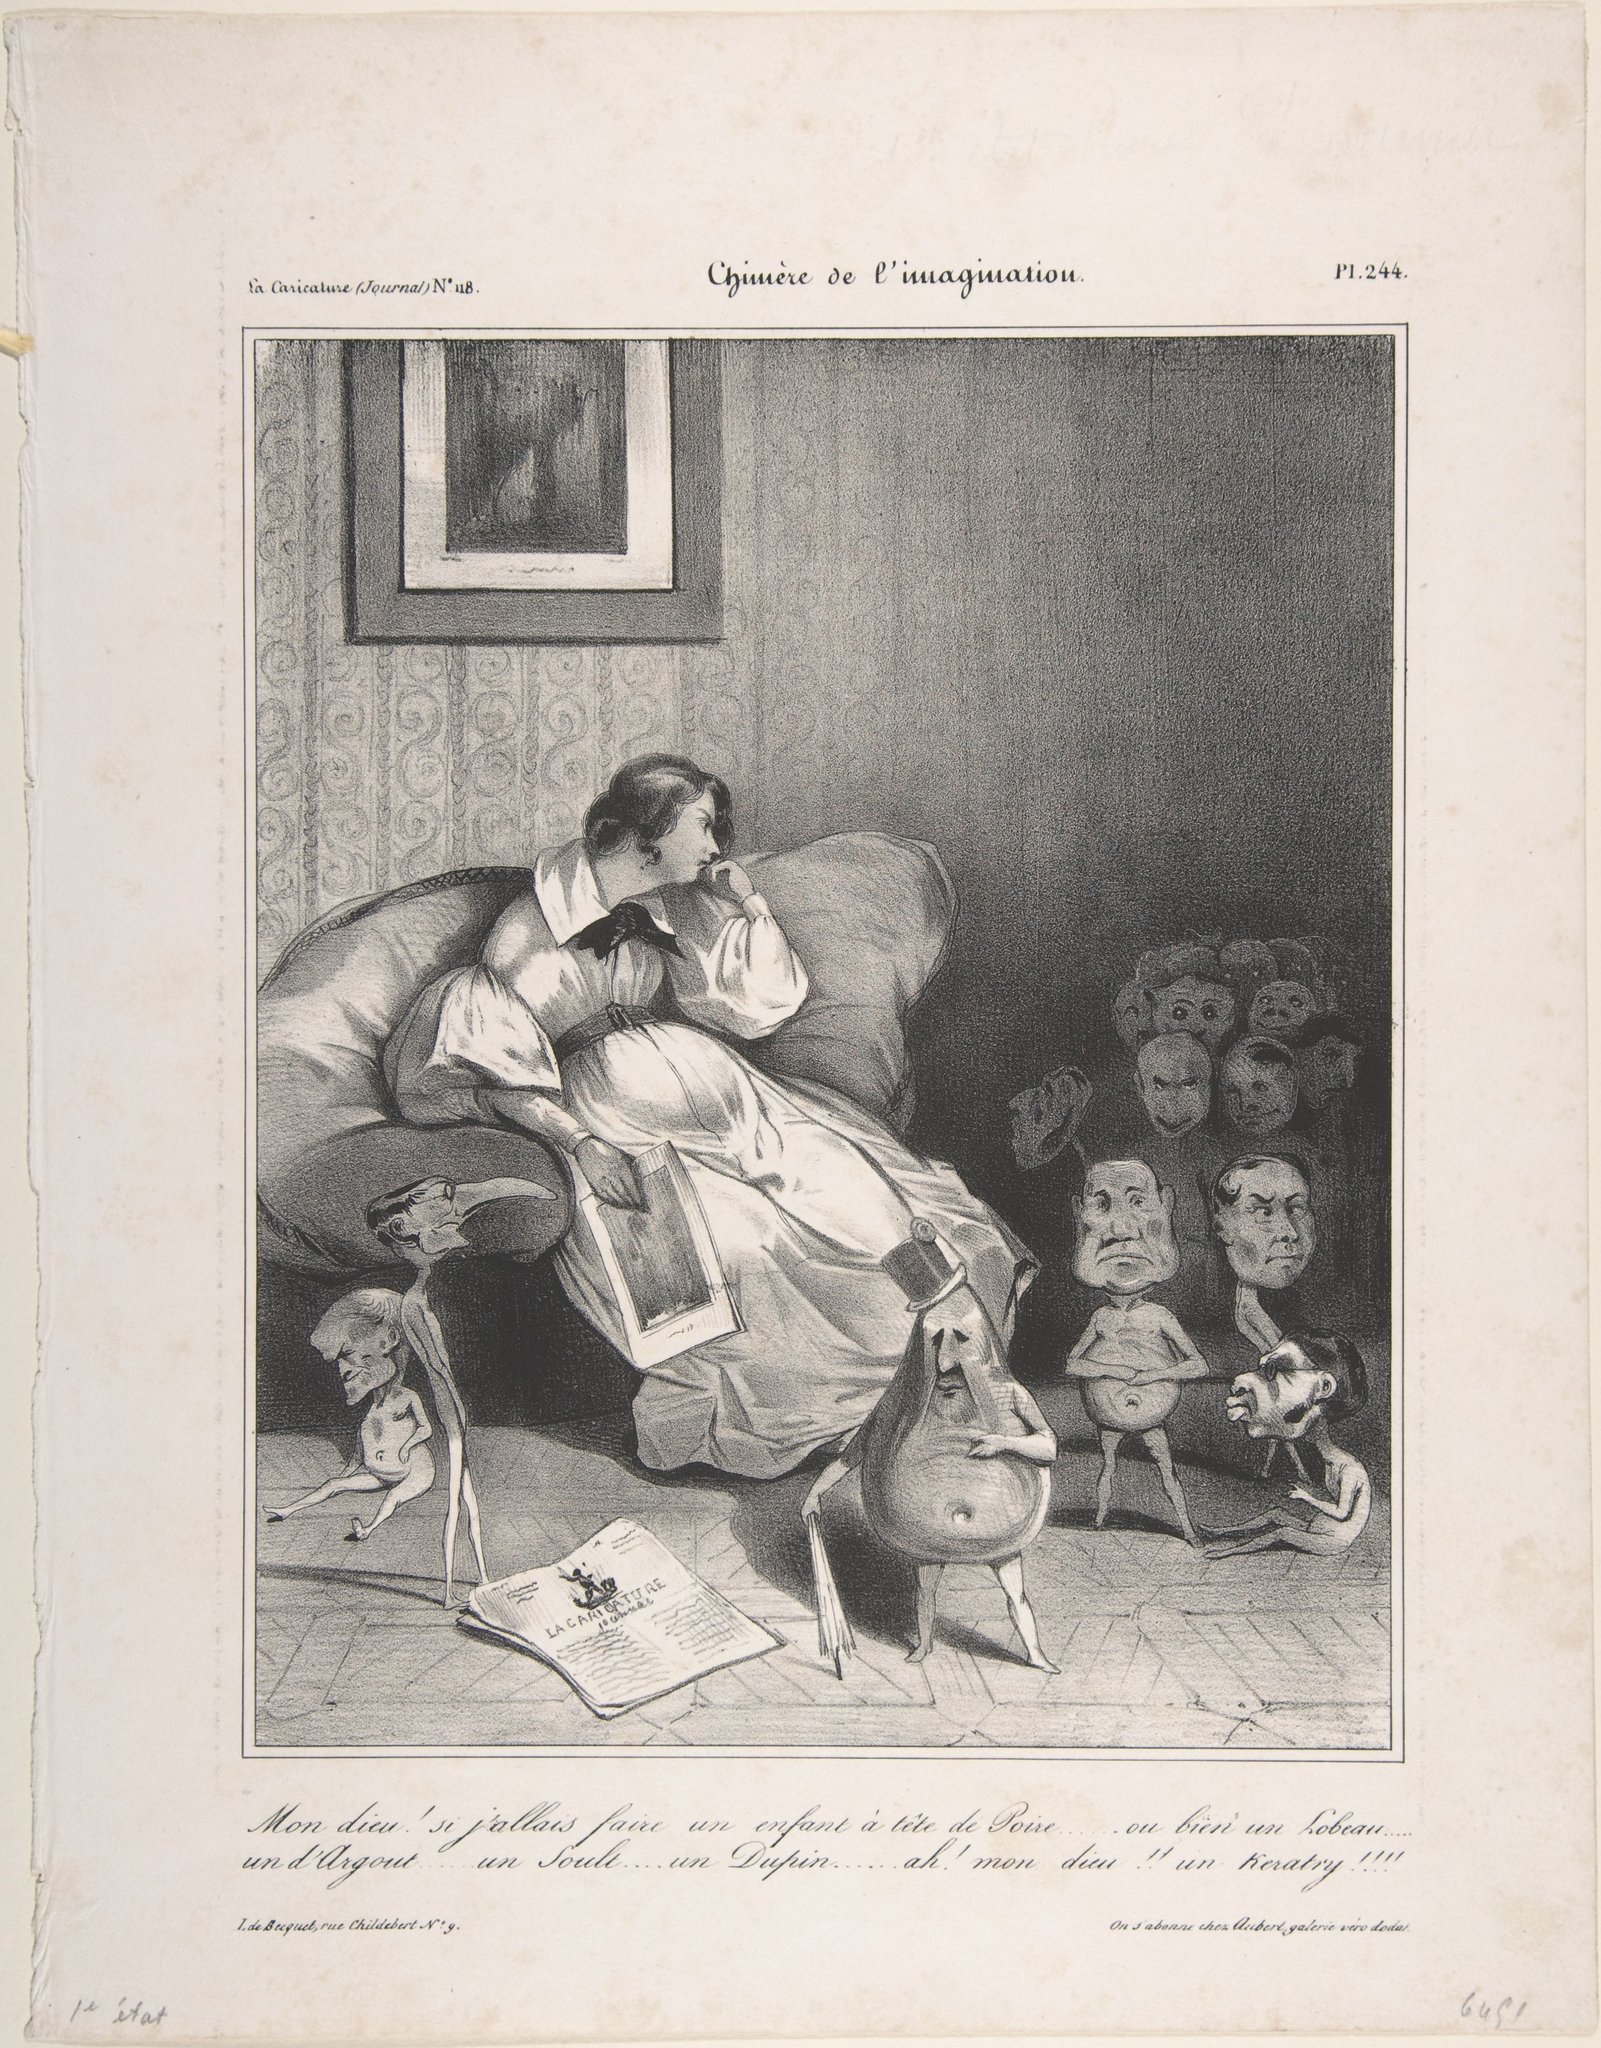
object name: print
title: Chimera of the imagination, from "La Caricature"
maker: honoré daumier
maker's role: artist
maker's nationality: french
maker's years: 1808-1879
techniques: lithograph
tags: women,caricature,politics